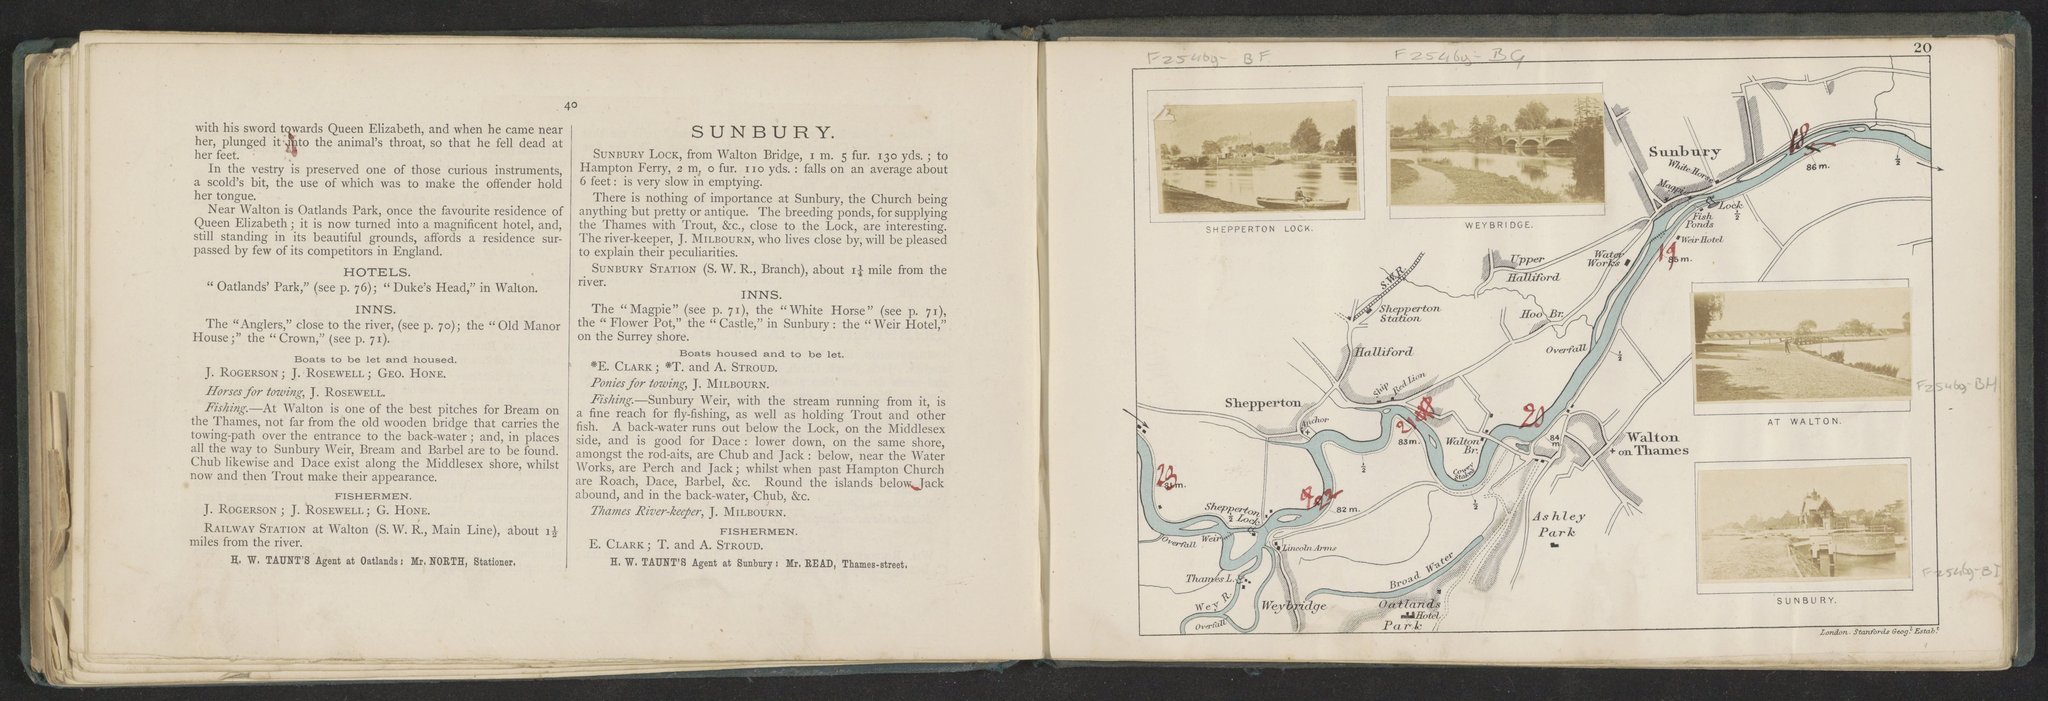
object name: page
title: Gezicht op een sluis in de Theems bij Sunbury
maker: henry w. taunt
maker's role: fotograaf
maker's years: 1842-1922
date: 1871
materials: photographic support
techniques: albumen print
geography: sunbury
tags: sluice, weir, river, thames